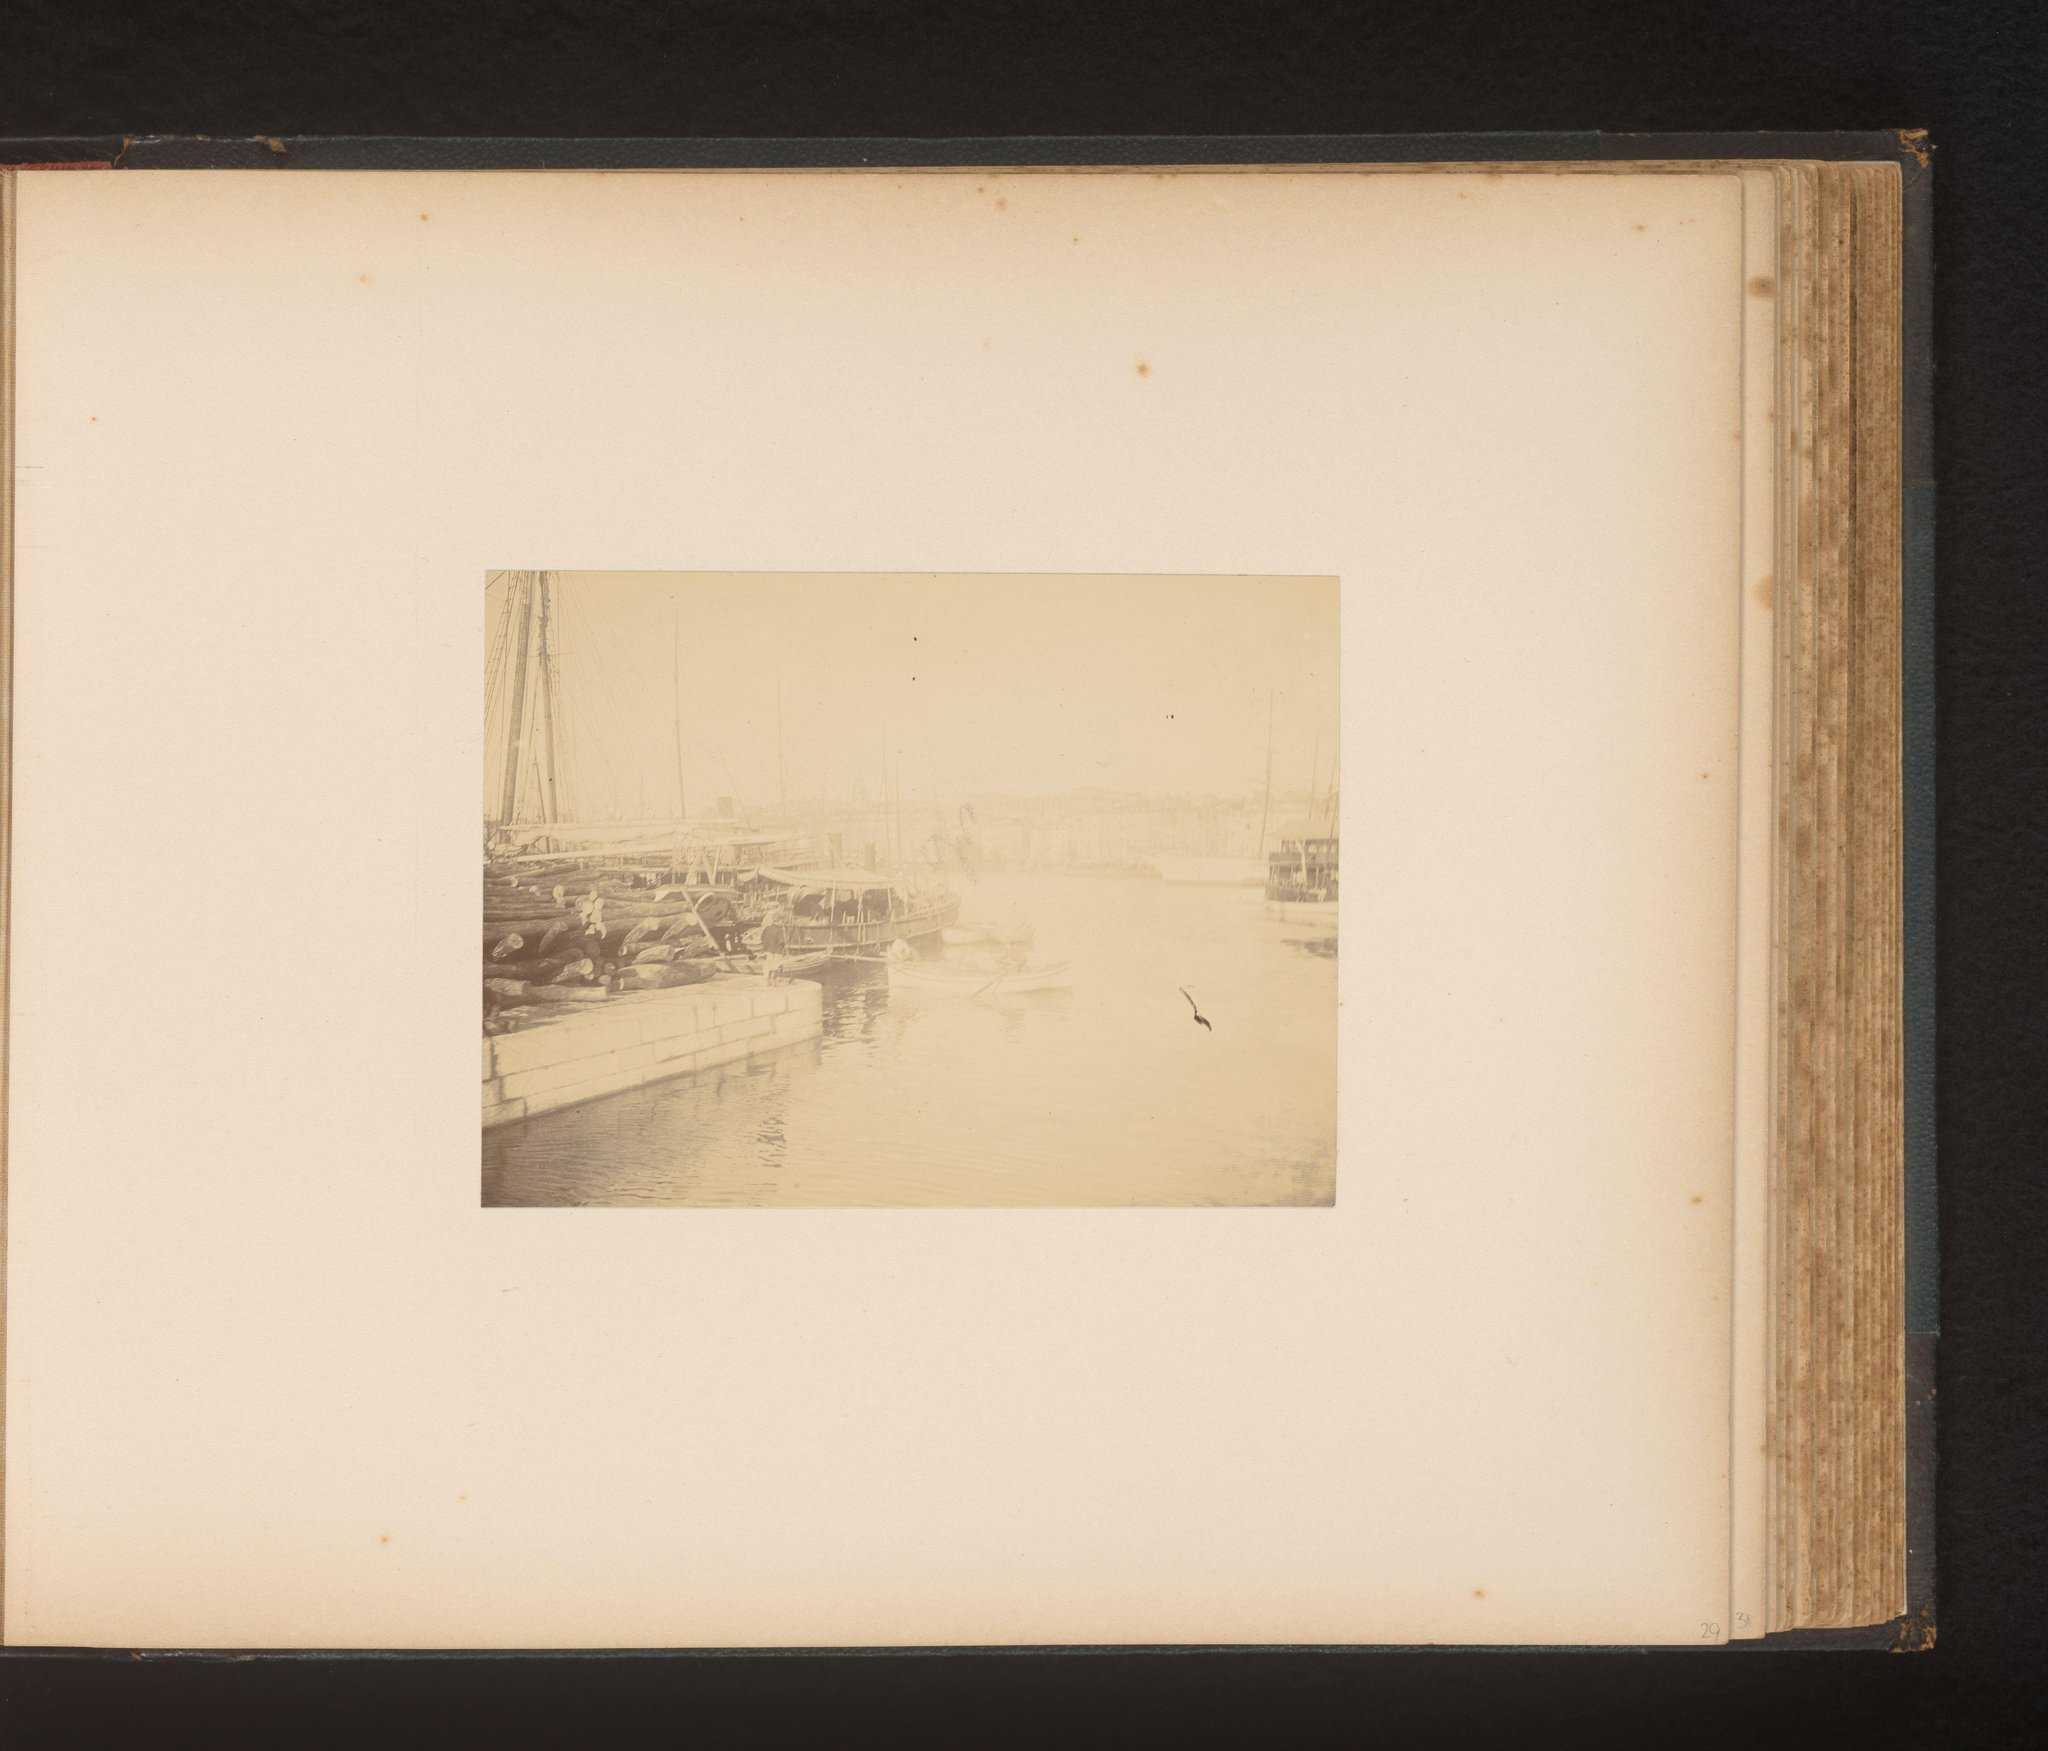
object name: album leaf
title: Aangemeerde schepen en een lading boomstammen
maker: Anonymous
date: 1880-1920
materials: cardboard, photographic support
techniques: gelatin silver print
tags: trees (+ stem, trunk), ships (in general), pier, quay, wharf, france